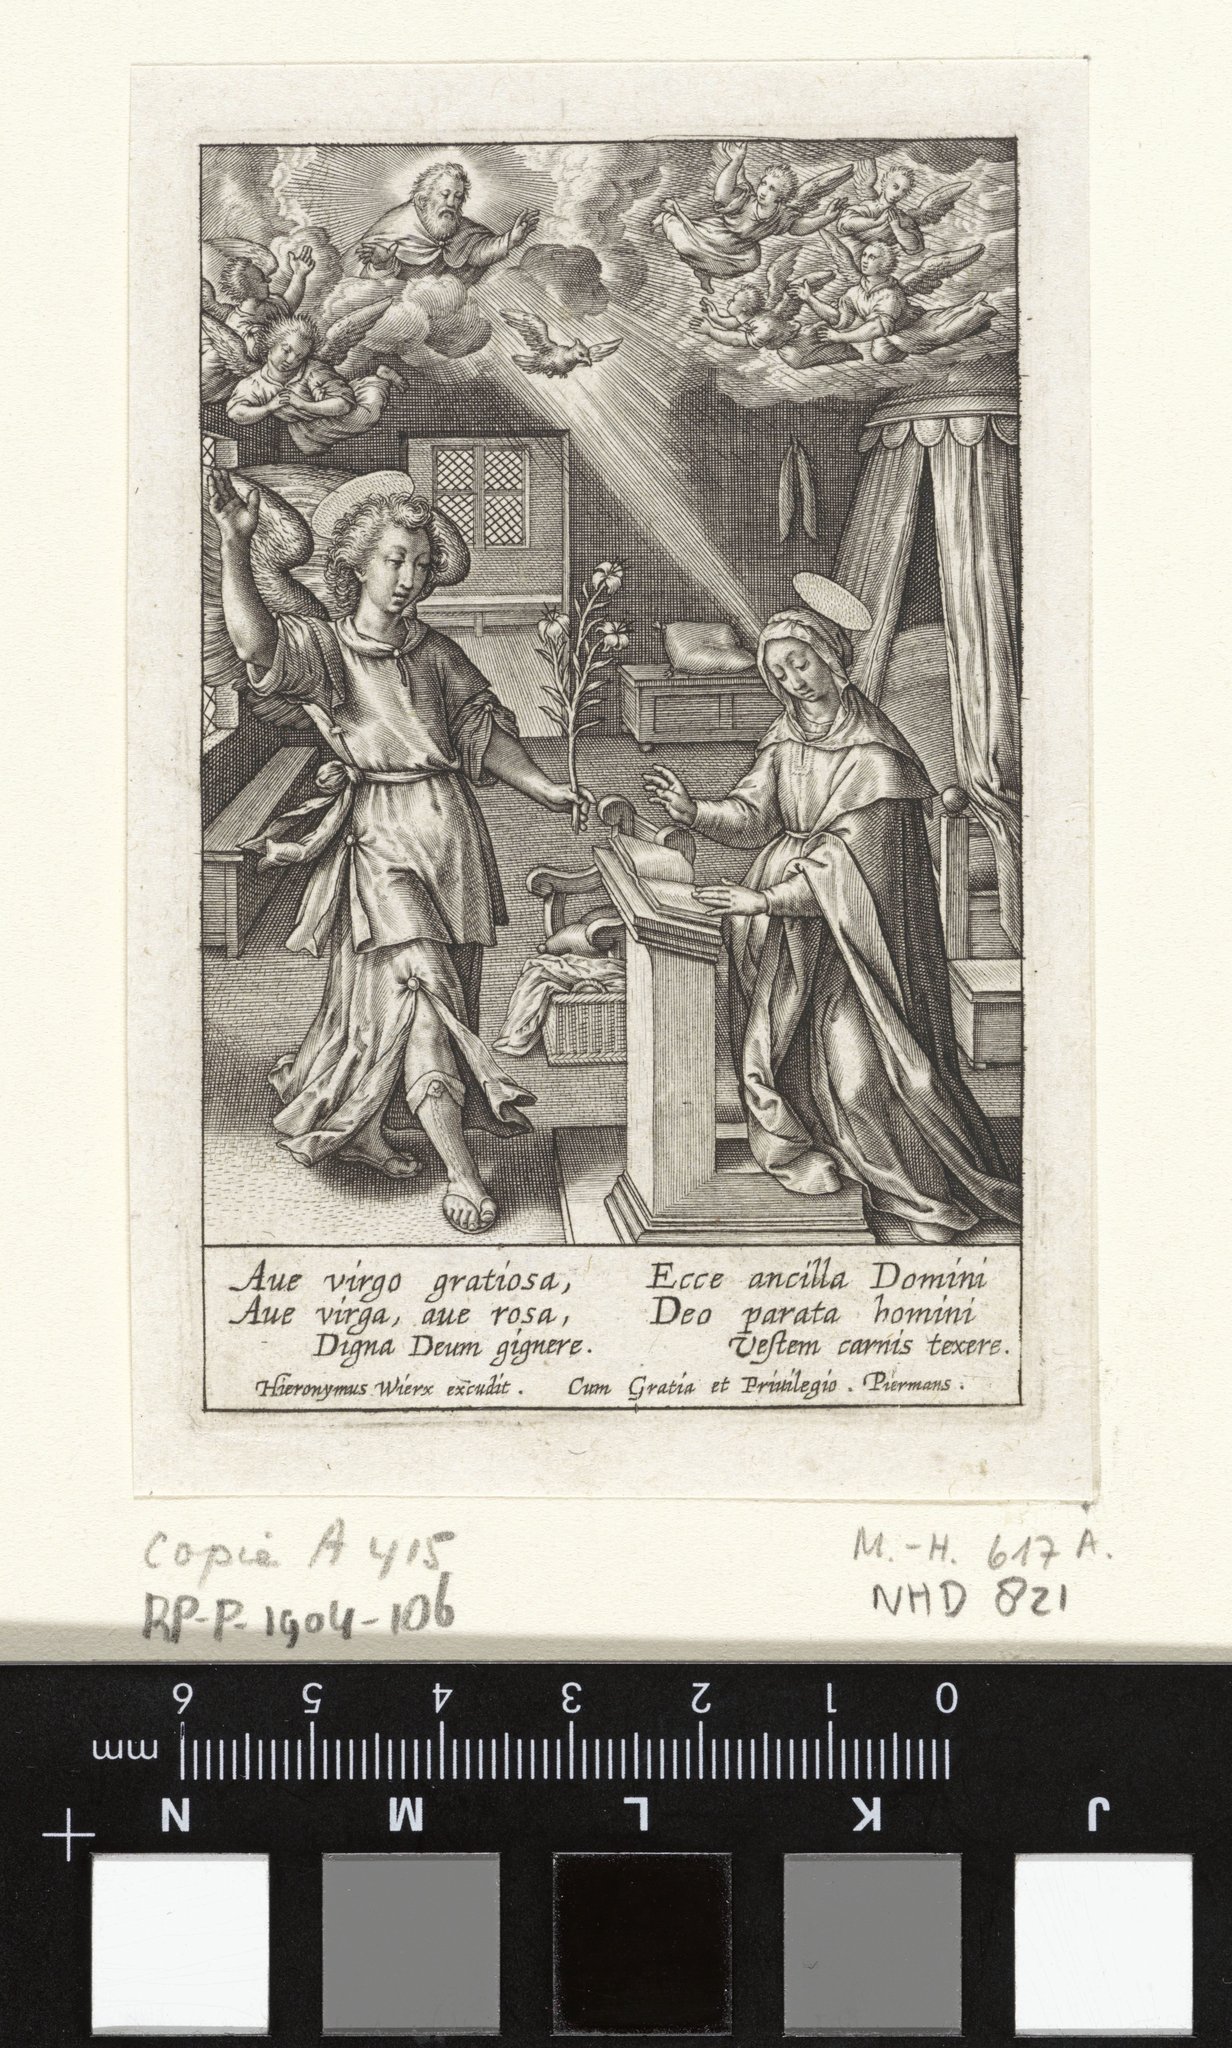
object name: print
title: Leven van de maagd Maria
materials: paper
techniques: engraving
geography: antwerp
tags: god the father, the annunciation: mary, usually reading, is visited by the angel (sometimes a woman overhears the conversation)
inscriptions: collector's mark: Lugt 2228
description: Maria zit geknield aan haar lessenaar in haar slaapvertrek. Ze wordt bezocht door de engel Gabriël. Hij vertelt haar dat ze een zoon zal baren die Christus zal heten. Boven hen laat God de Vader de duif van de Heilige Geest op haar neer dalen. Engelen kijken toe vanuit de hemel. In de marge een zesregelig onderschrift, in twee kolommen, in het Latijn.